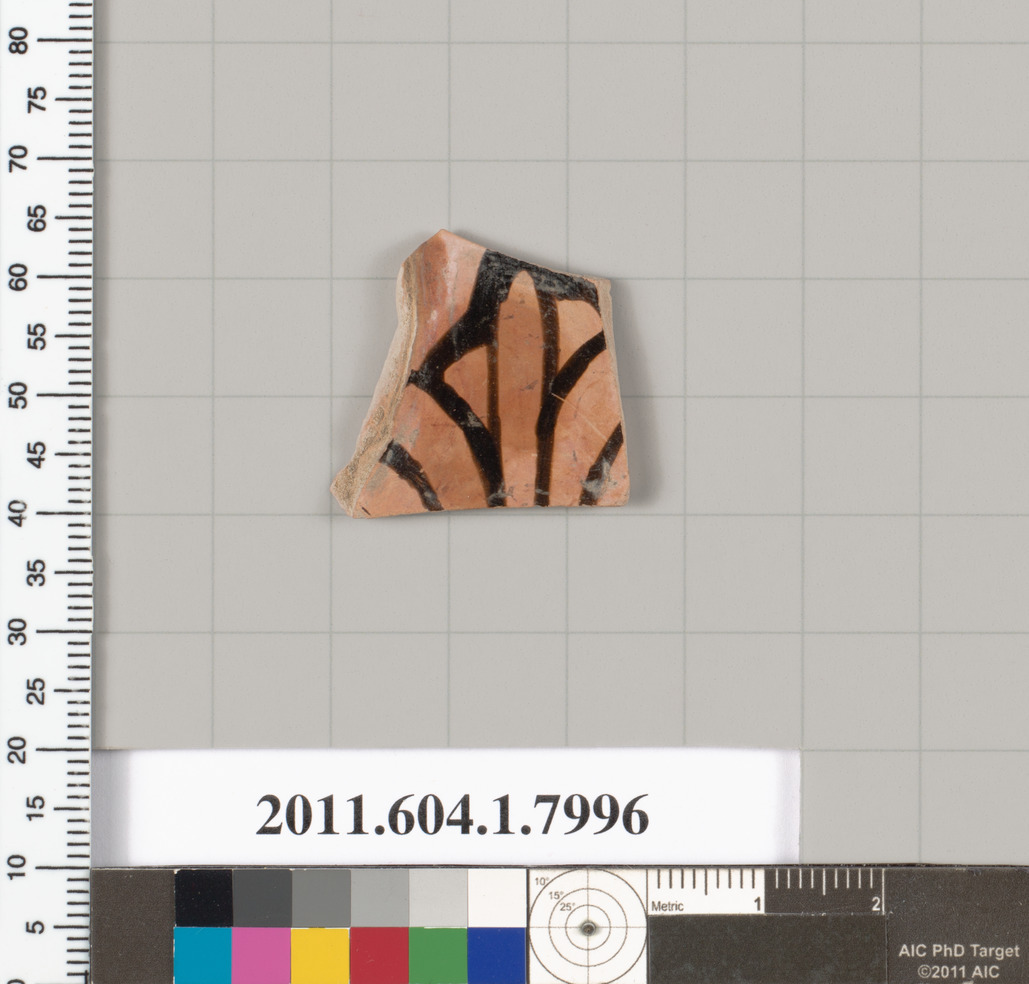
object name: kylix fragment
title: Terracotta fragment of a kylix (drinking cup)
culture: greek, attic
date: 460-450 BCE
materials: terracotta